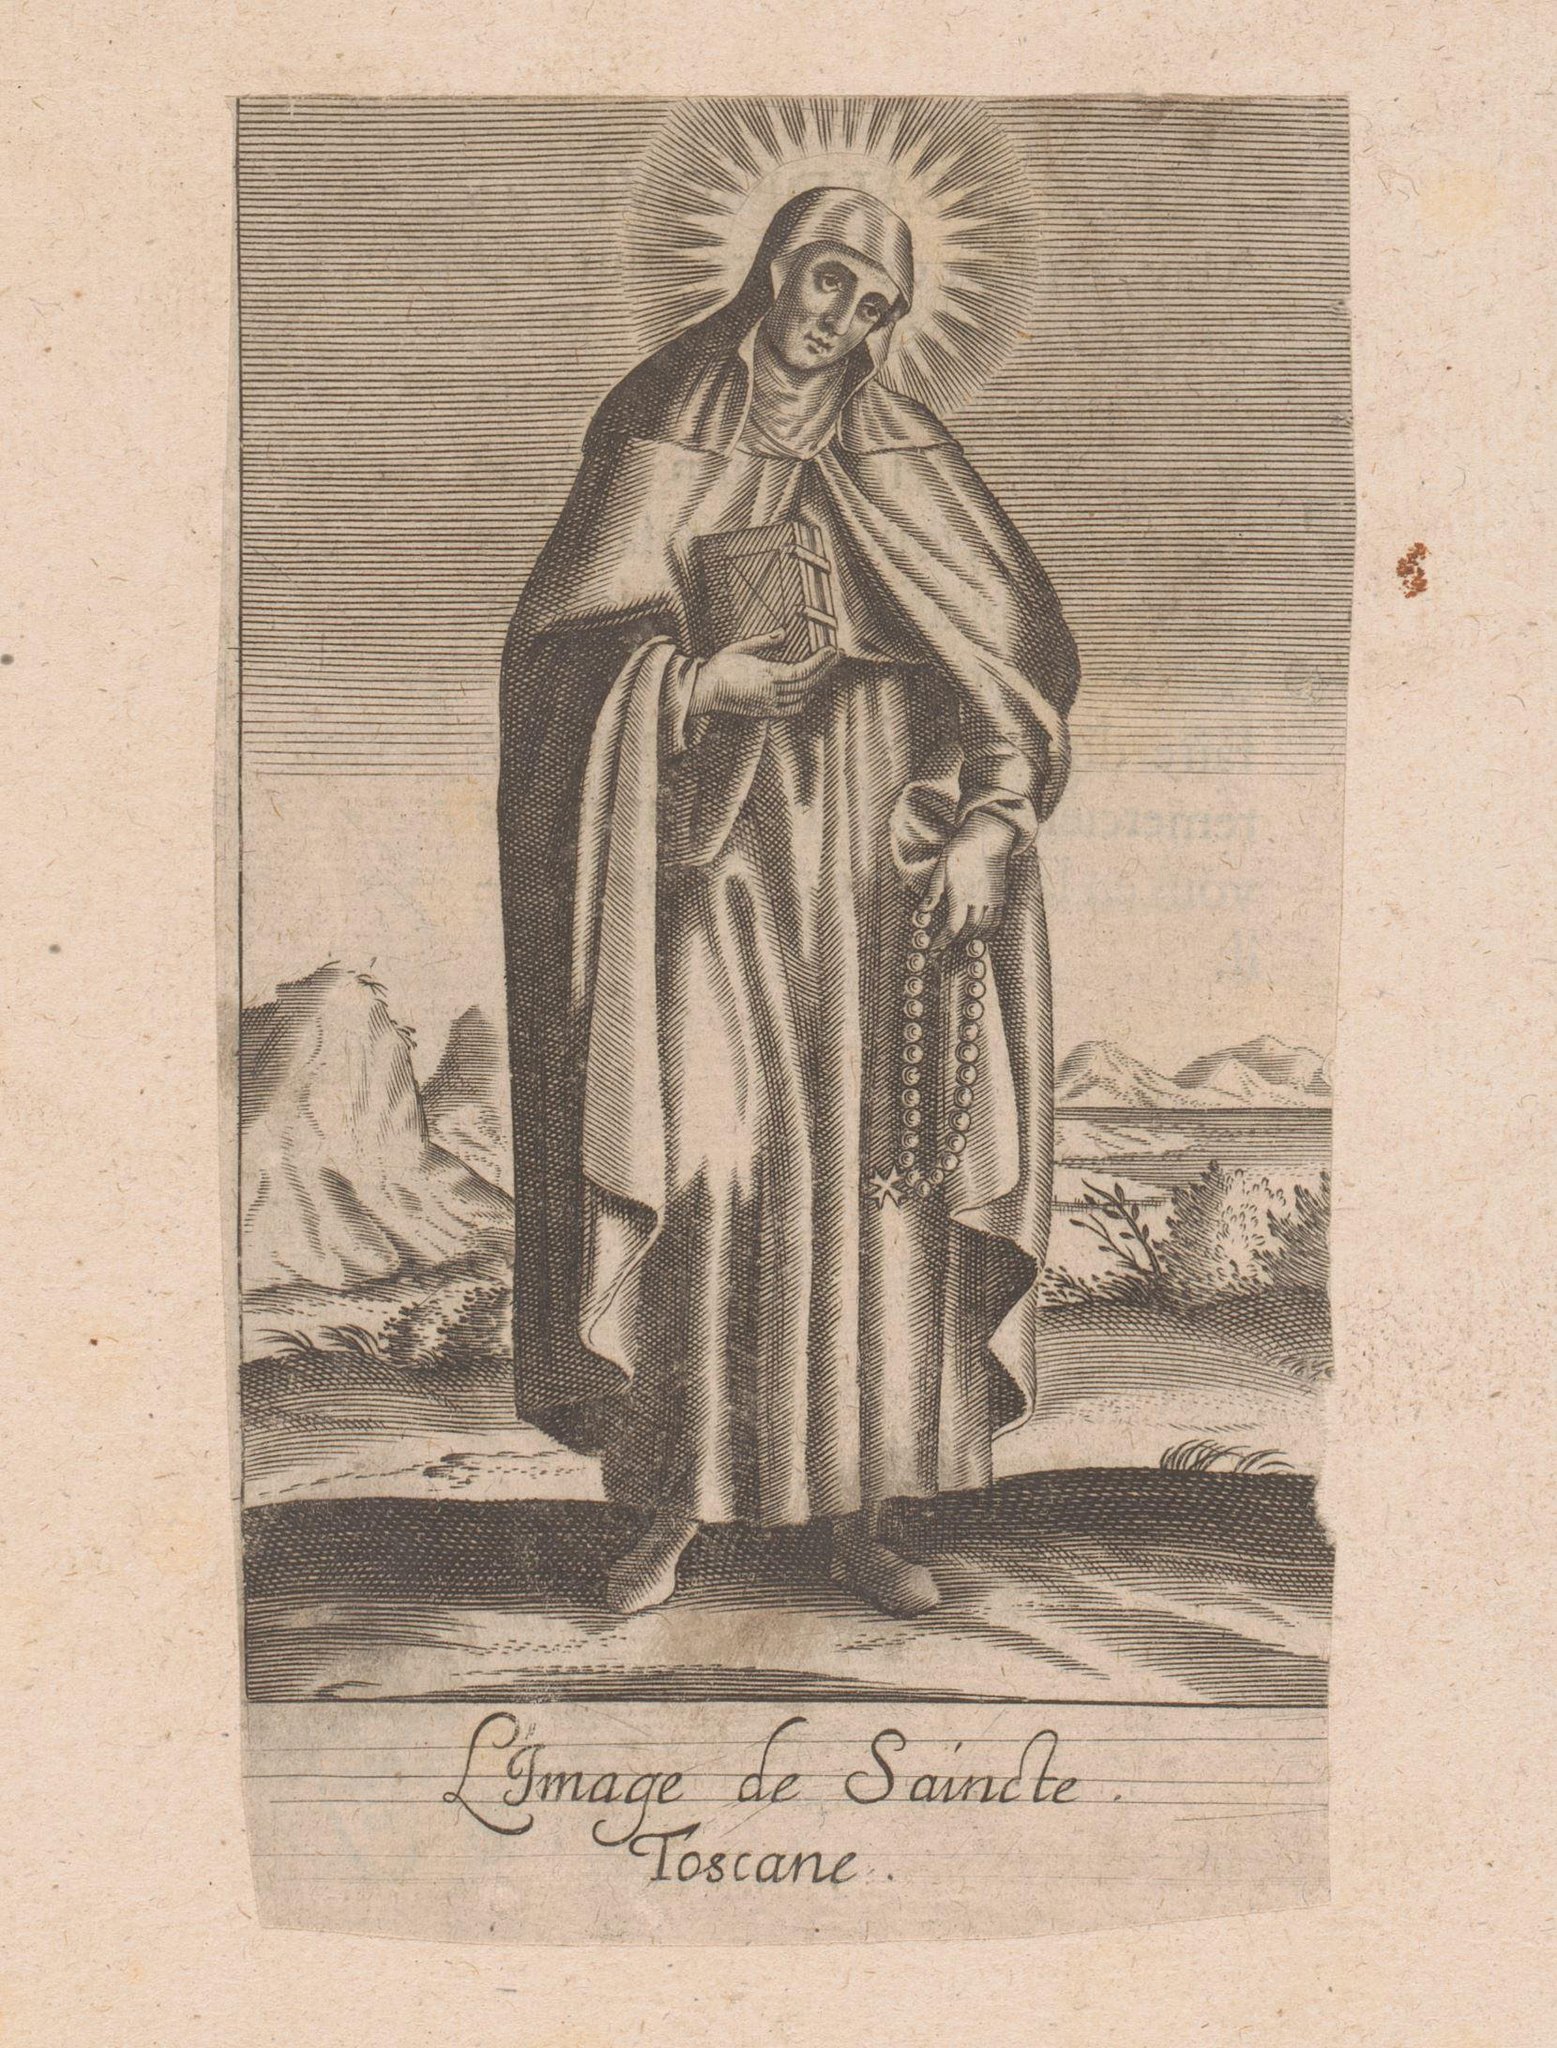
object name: print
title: L'Image de Saincte Toscane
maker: Anonymous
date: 1600-1650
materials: paper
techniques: engraving, letterpress printing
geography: france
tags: female saints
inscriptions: collector's mark: Lugt 2228